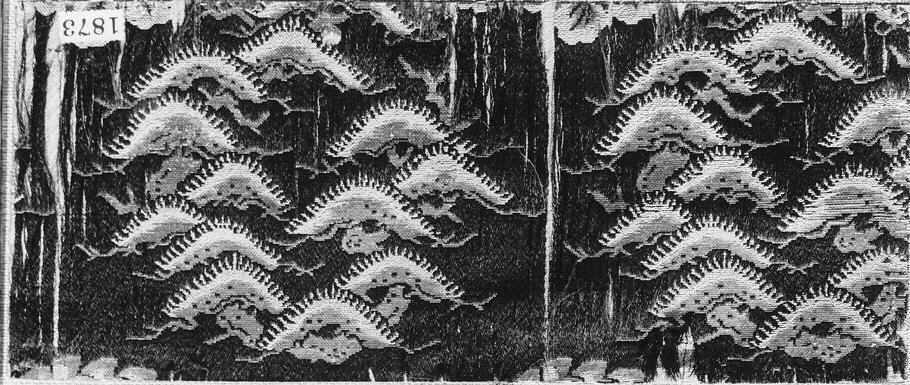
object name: piece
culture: japanese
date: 1615-1868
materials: metal thread, silk